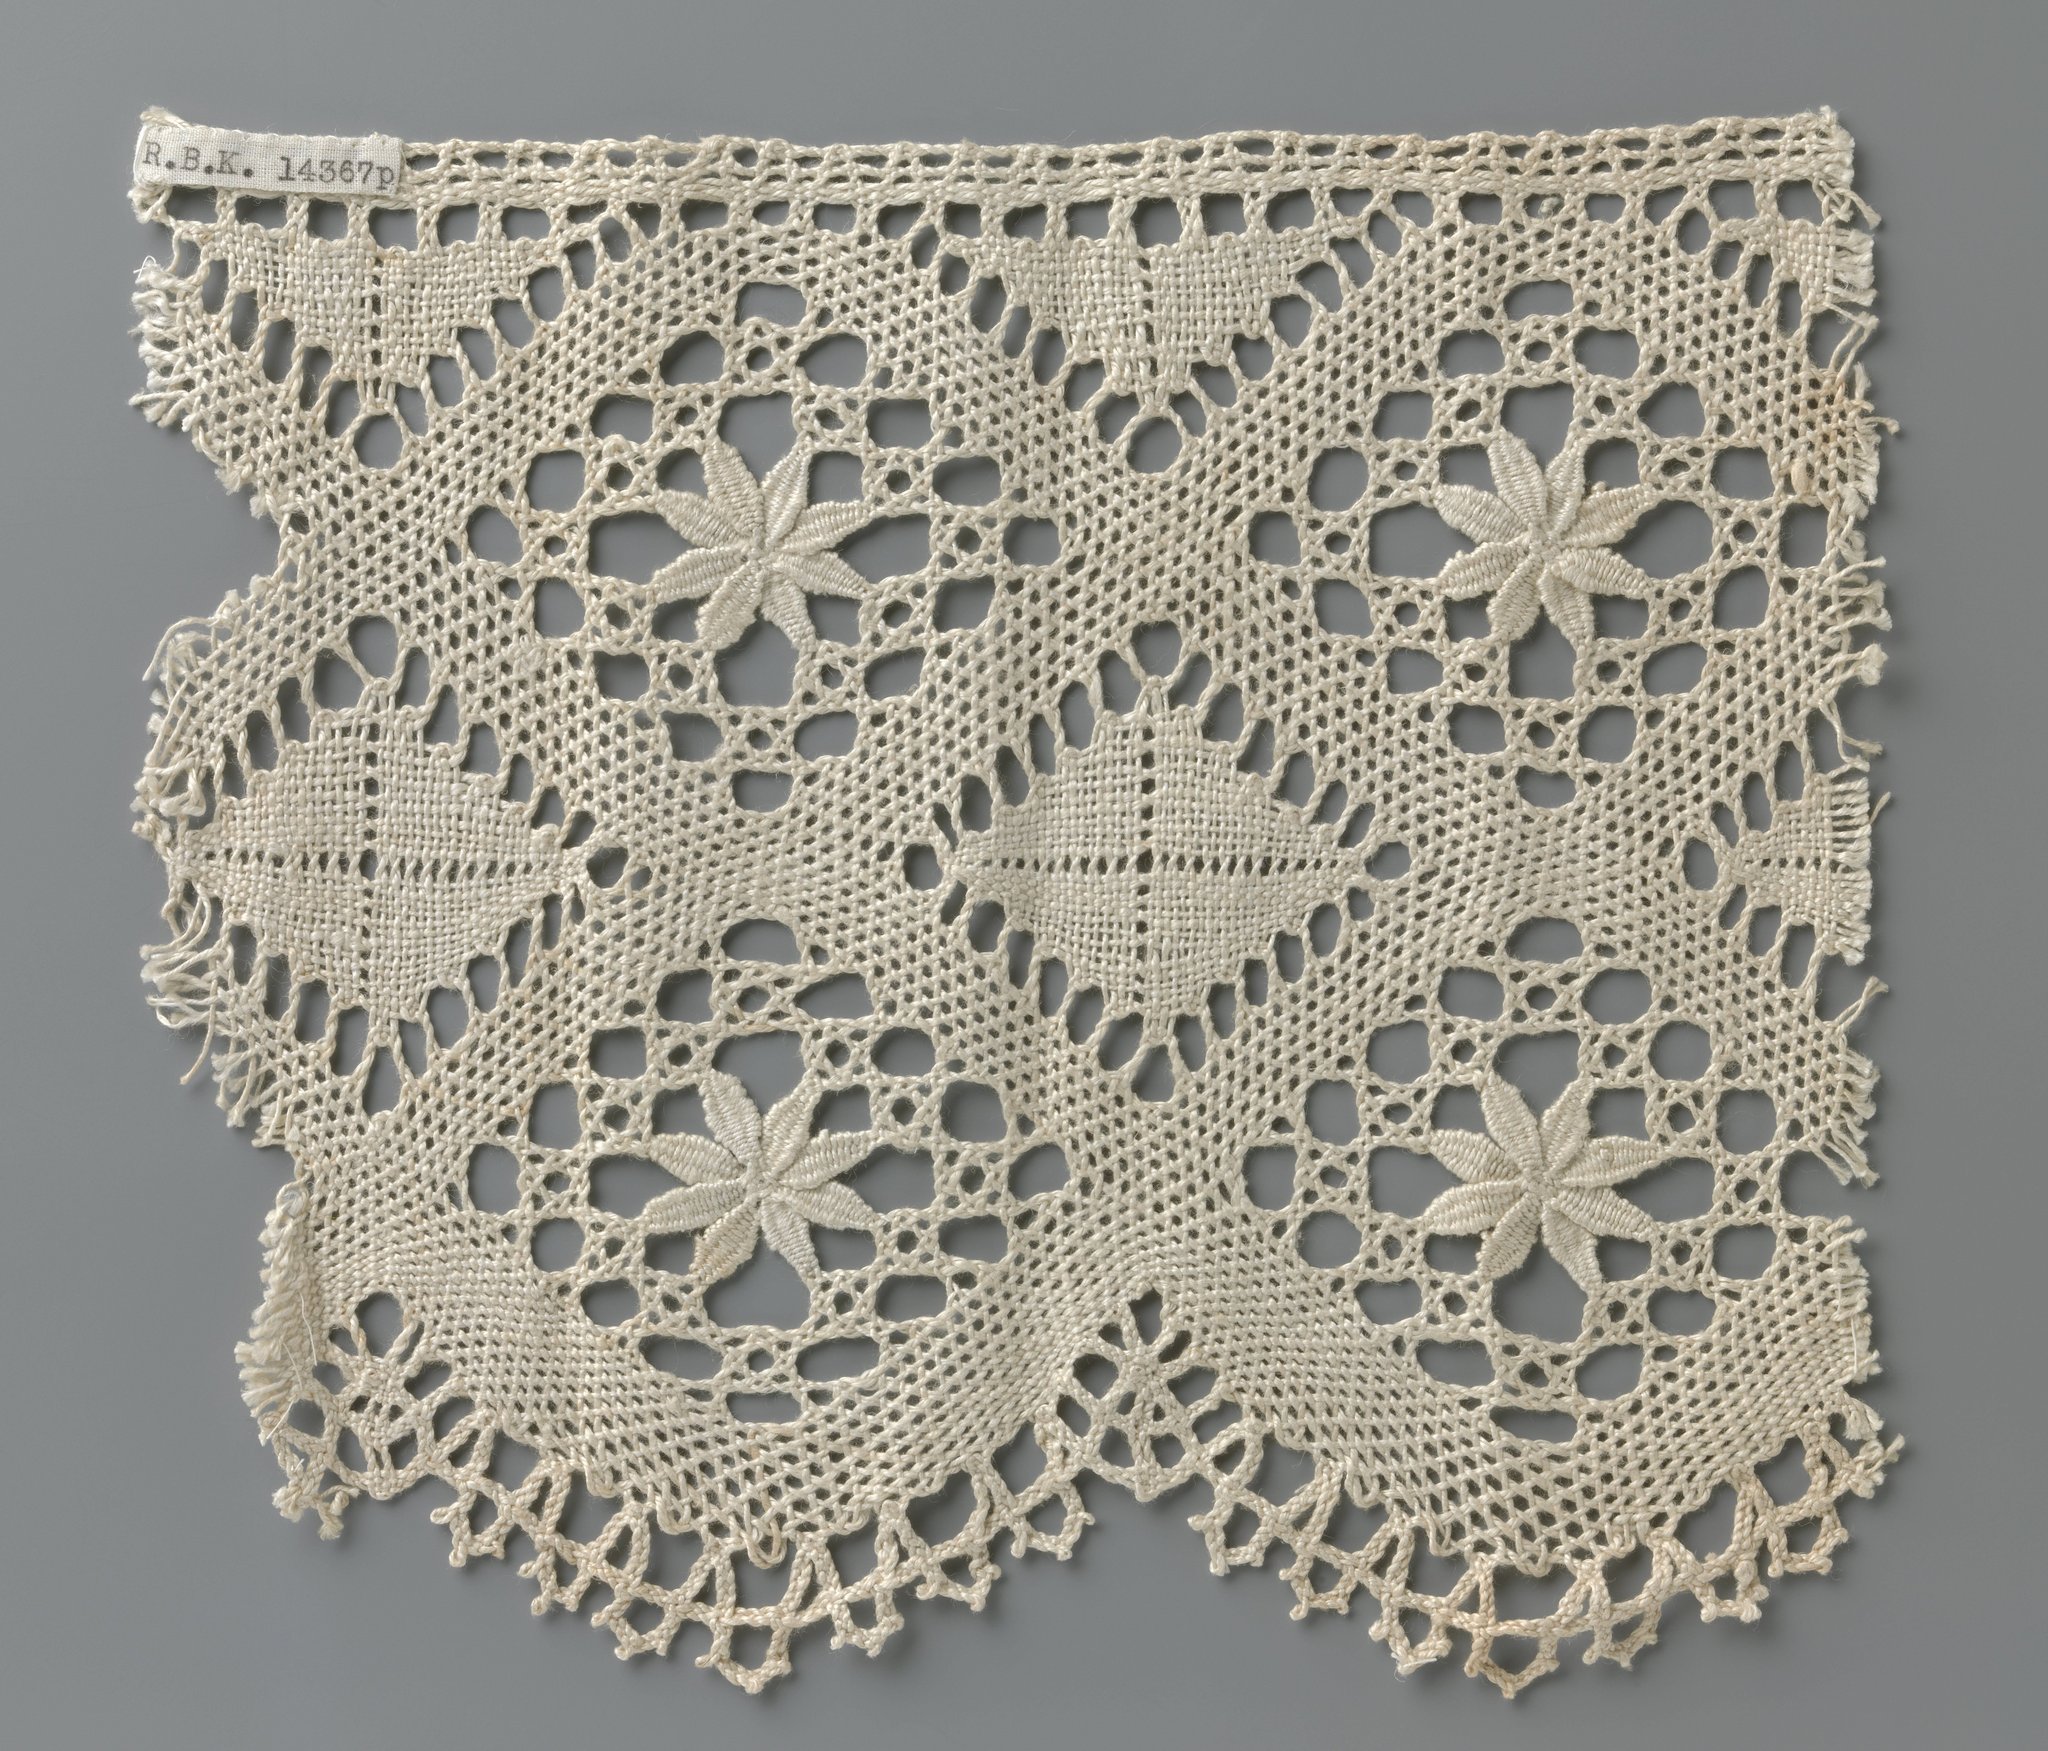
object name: strip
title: Strook kloskant met drie rijen ruiten en halfronde schulpen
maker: Anonymous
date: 1900-1915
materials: linen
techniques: lace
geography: bohemia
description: Strook naturelkleurige kloskant: Cluny-kant. Het zich herhalende en symmetrische patroon bestaat uit diagonale banen geklost in netslag, die drie rijen ruitvormige velden vormen en een bovenste vierde rij met driehoekige velden, halve ruiten. De middelste veldrij is gevuld met ruiten in linnenslag waarin een kruis is gemaakt met kleine uitsparingen. De halve versie hiervan staat in de bovenste rij. De andere velden zijn gevuld met een vijfgaatjesgrond en heeft in het centrum een bloem met acht bloemblaadjes geklost in vormslag. De halfronde schulpenrand wordt gevormd doordat de diagonale lijnen hier afgerond zijn. De schulpenrand is afgewerkt met een boogjesrandje gevormd door een sterk kronkelend vlechtje met picots.